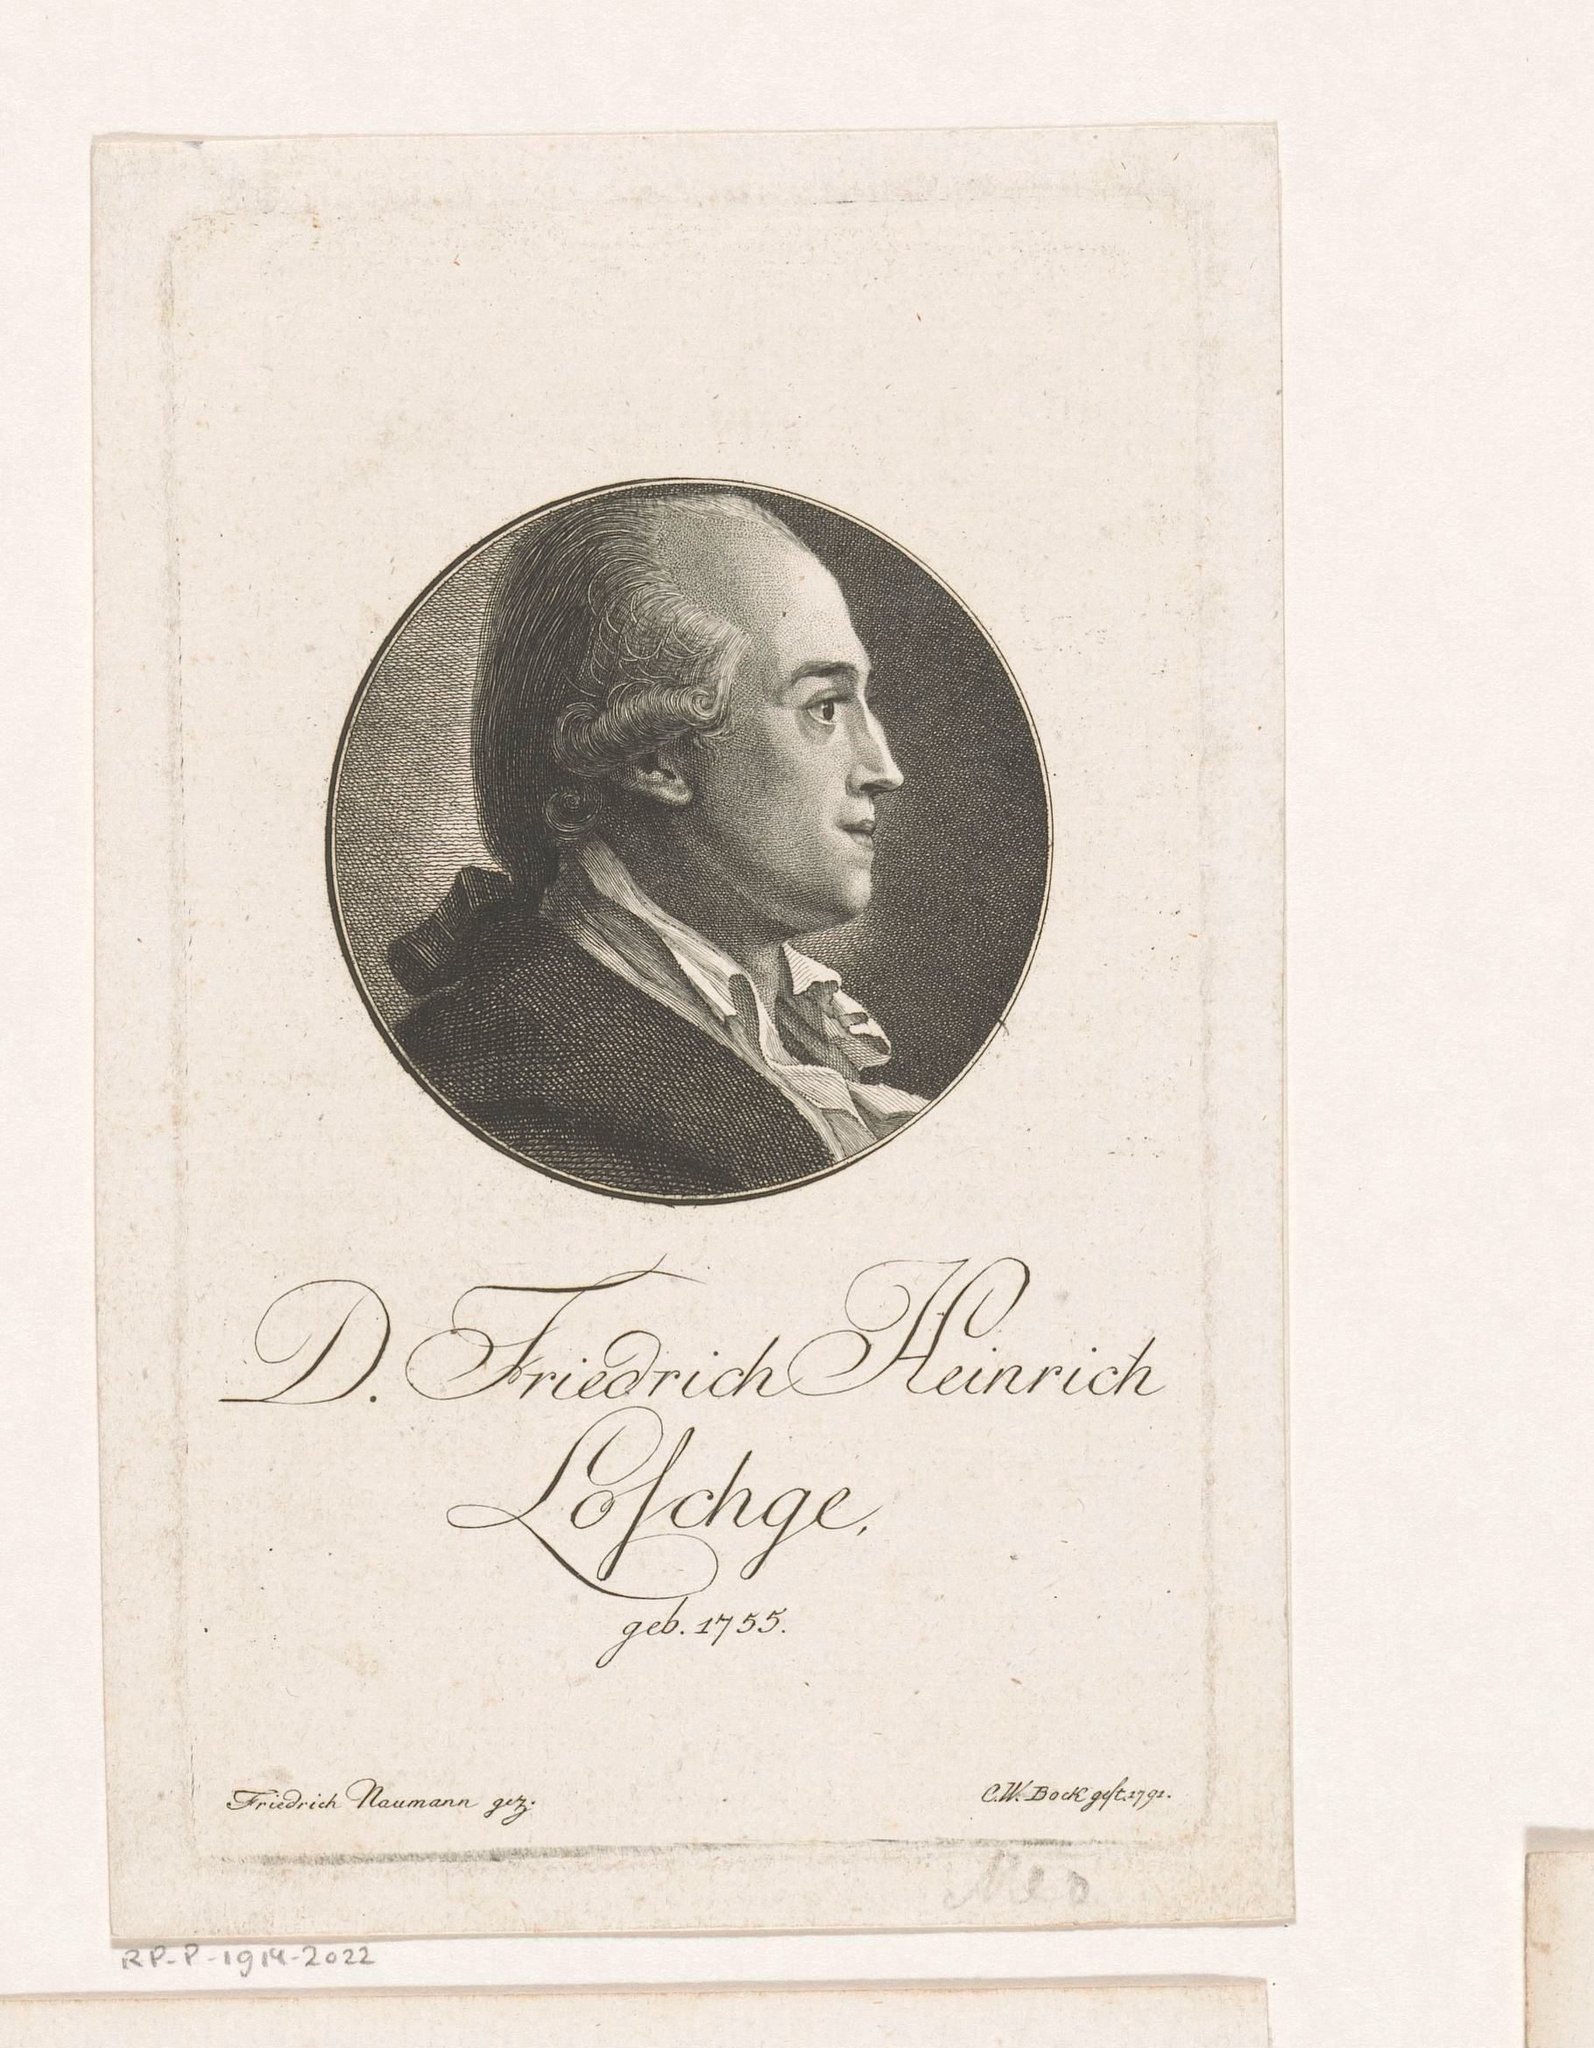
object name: print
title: Portret van Friedrich Heinrich Loschge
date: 1791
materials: paper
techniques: engraving, etching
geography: nuremberg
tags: historical persons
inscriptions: collector's mark: Lugt 2228